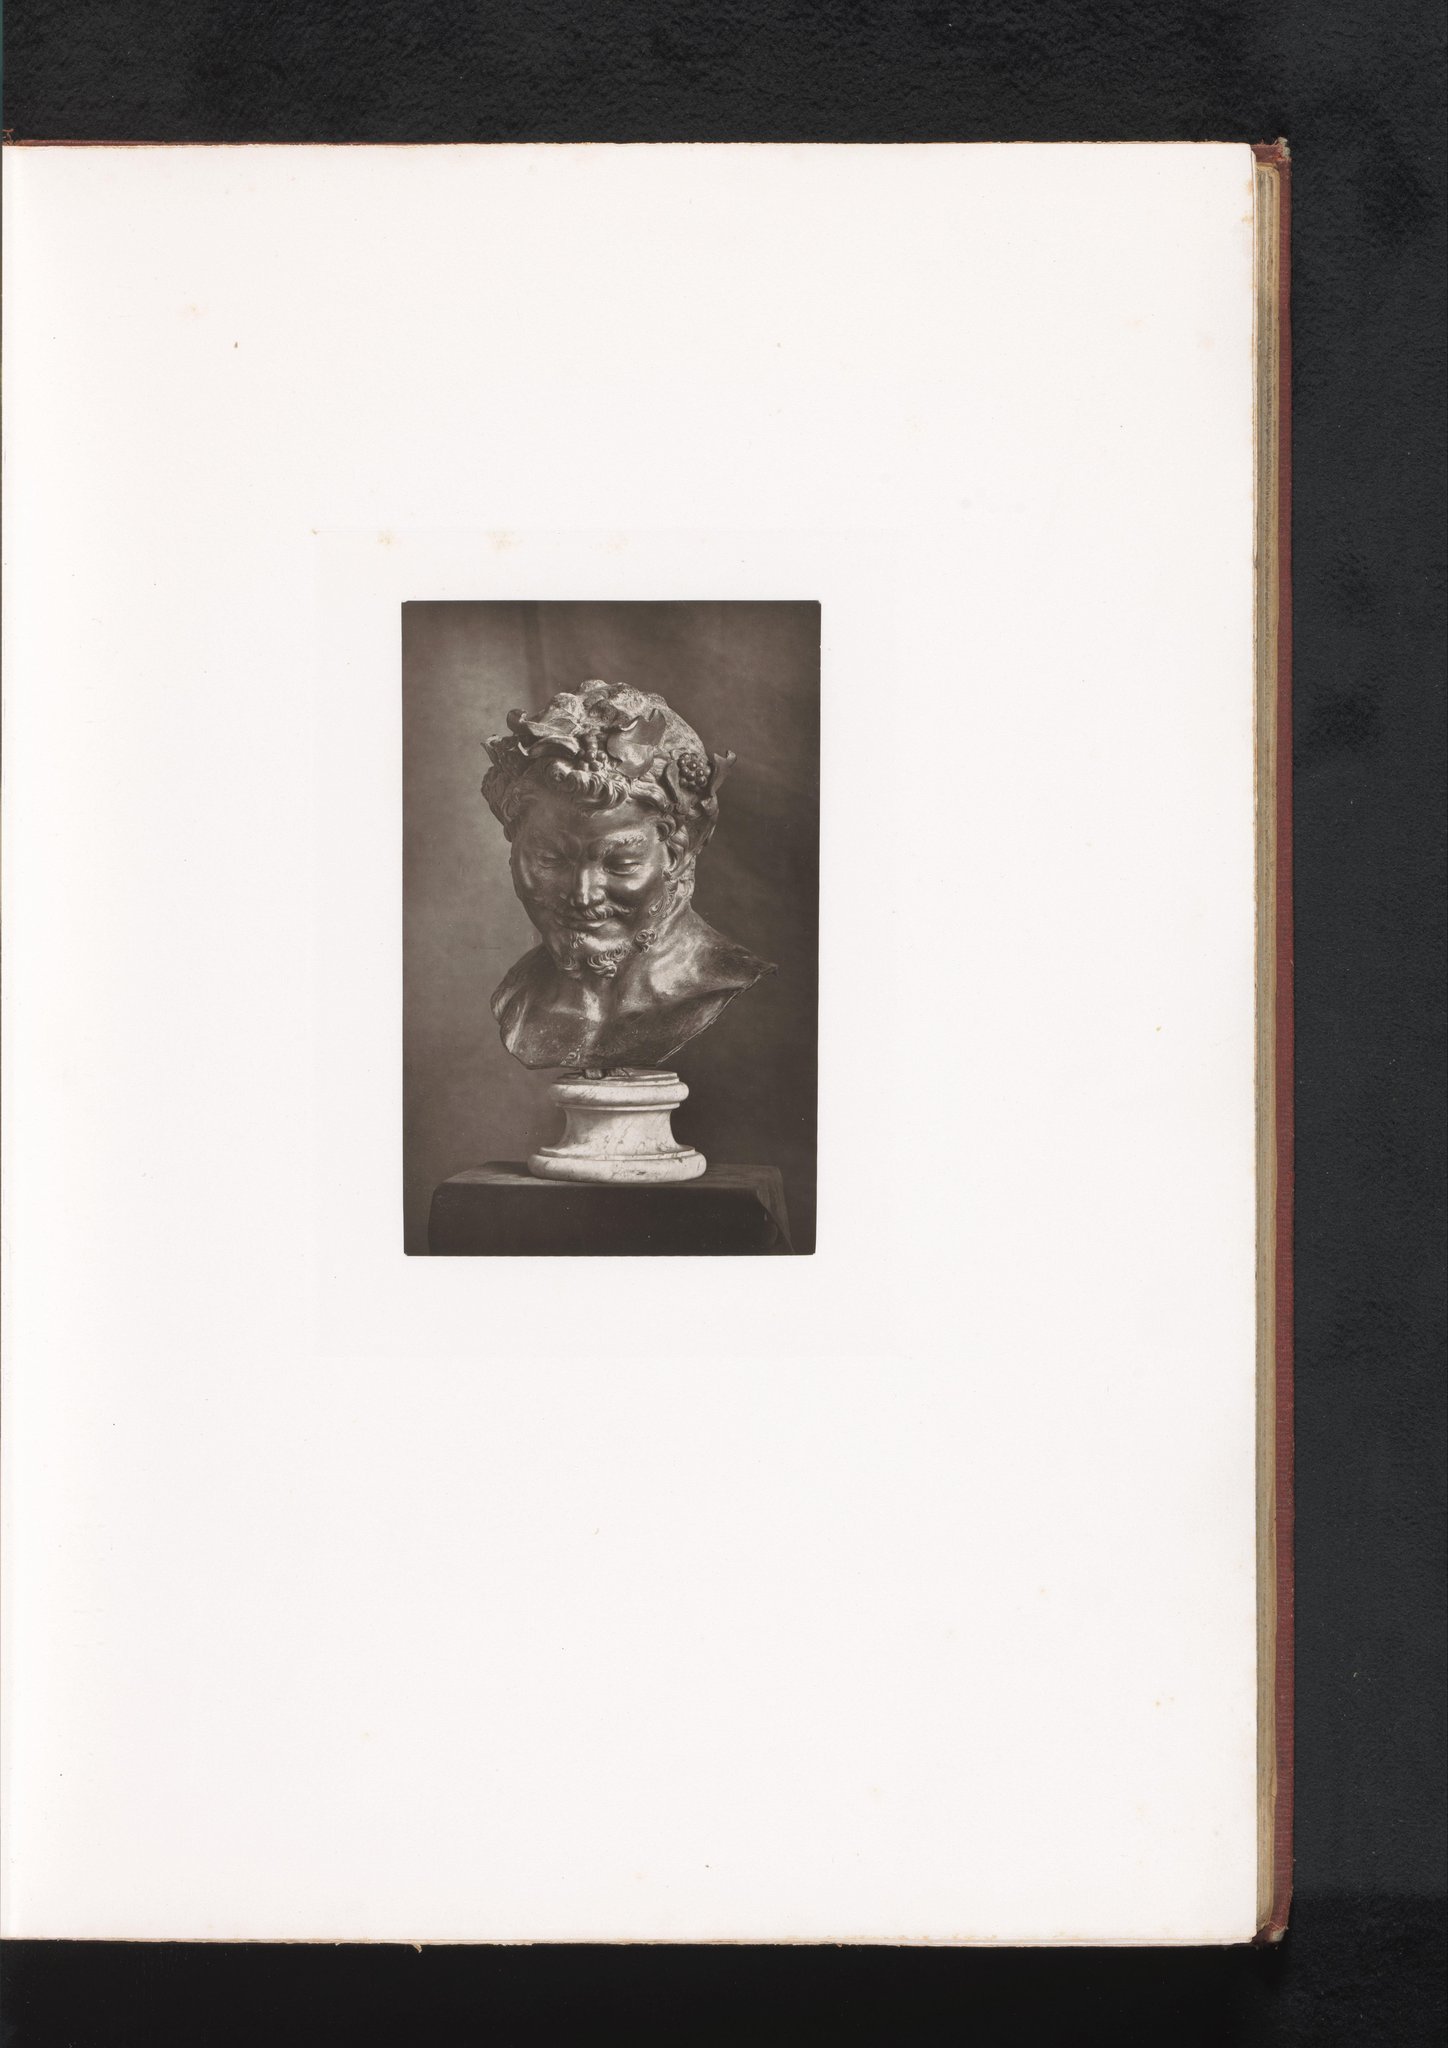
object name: photomechanical print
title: Sculptuur van het hoofd van een faun, opgesteld tijdens de Exposition Rétrospective van 1873 in Tours, Frankrijk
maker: gabriel blaise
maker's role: printer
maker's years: 1827-1897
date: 1873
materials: paper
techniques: woodburytype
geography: tours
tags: satyrs, fauns, sileni, piece of sculpture, reproduction of a piece of sculpture, temporary exhibition, 'salon'